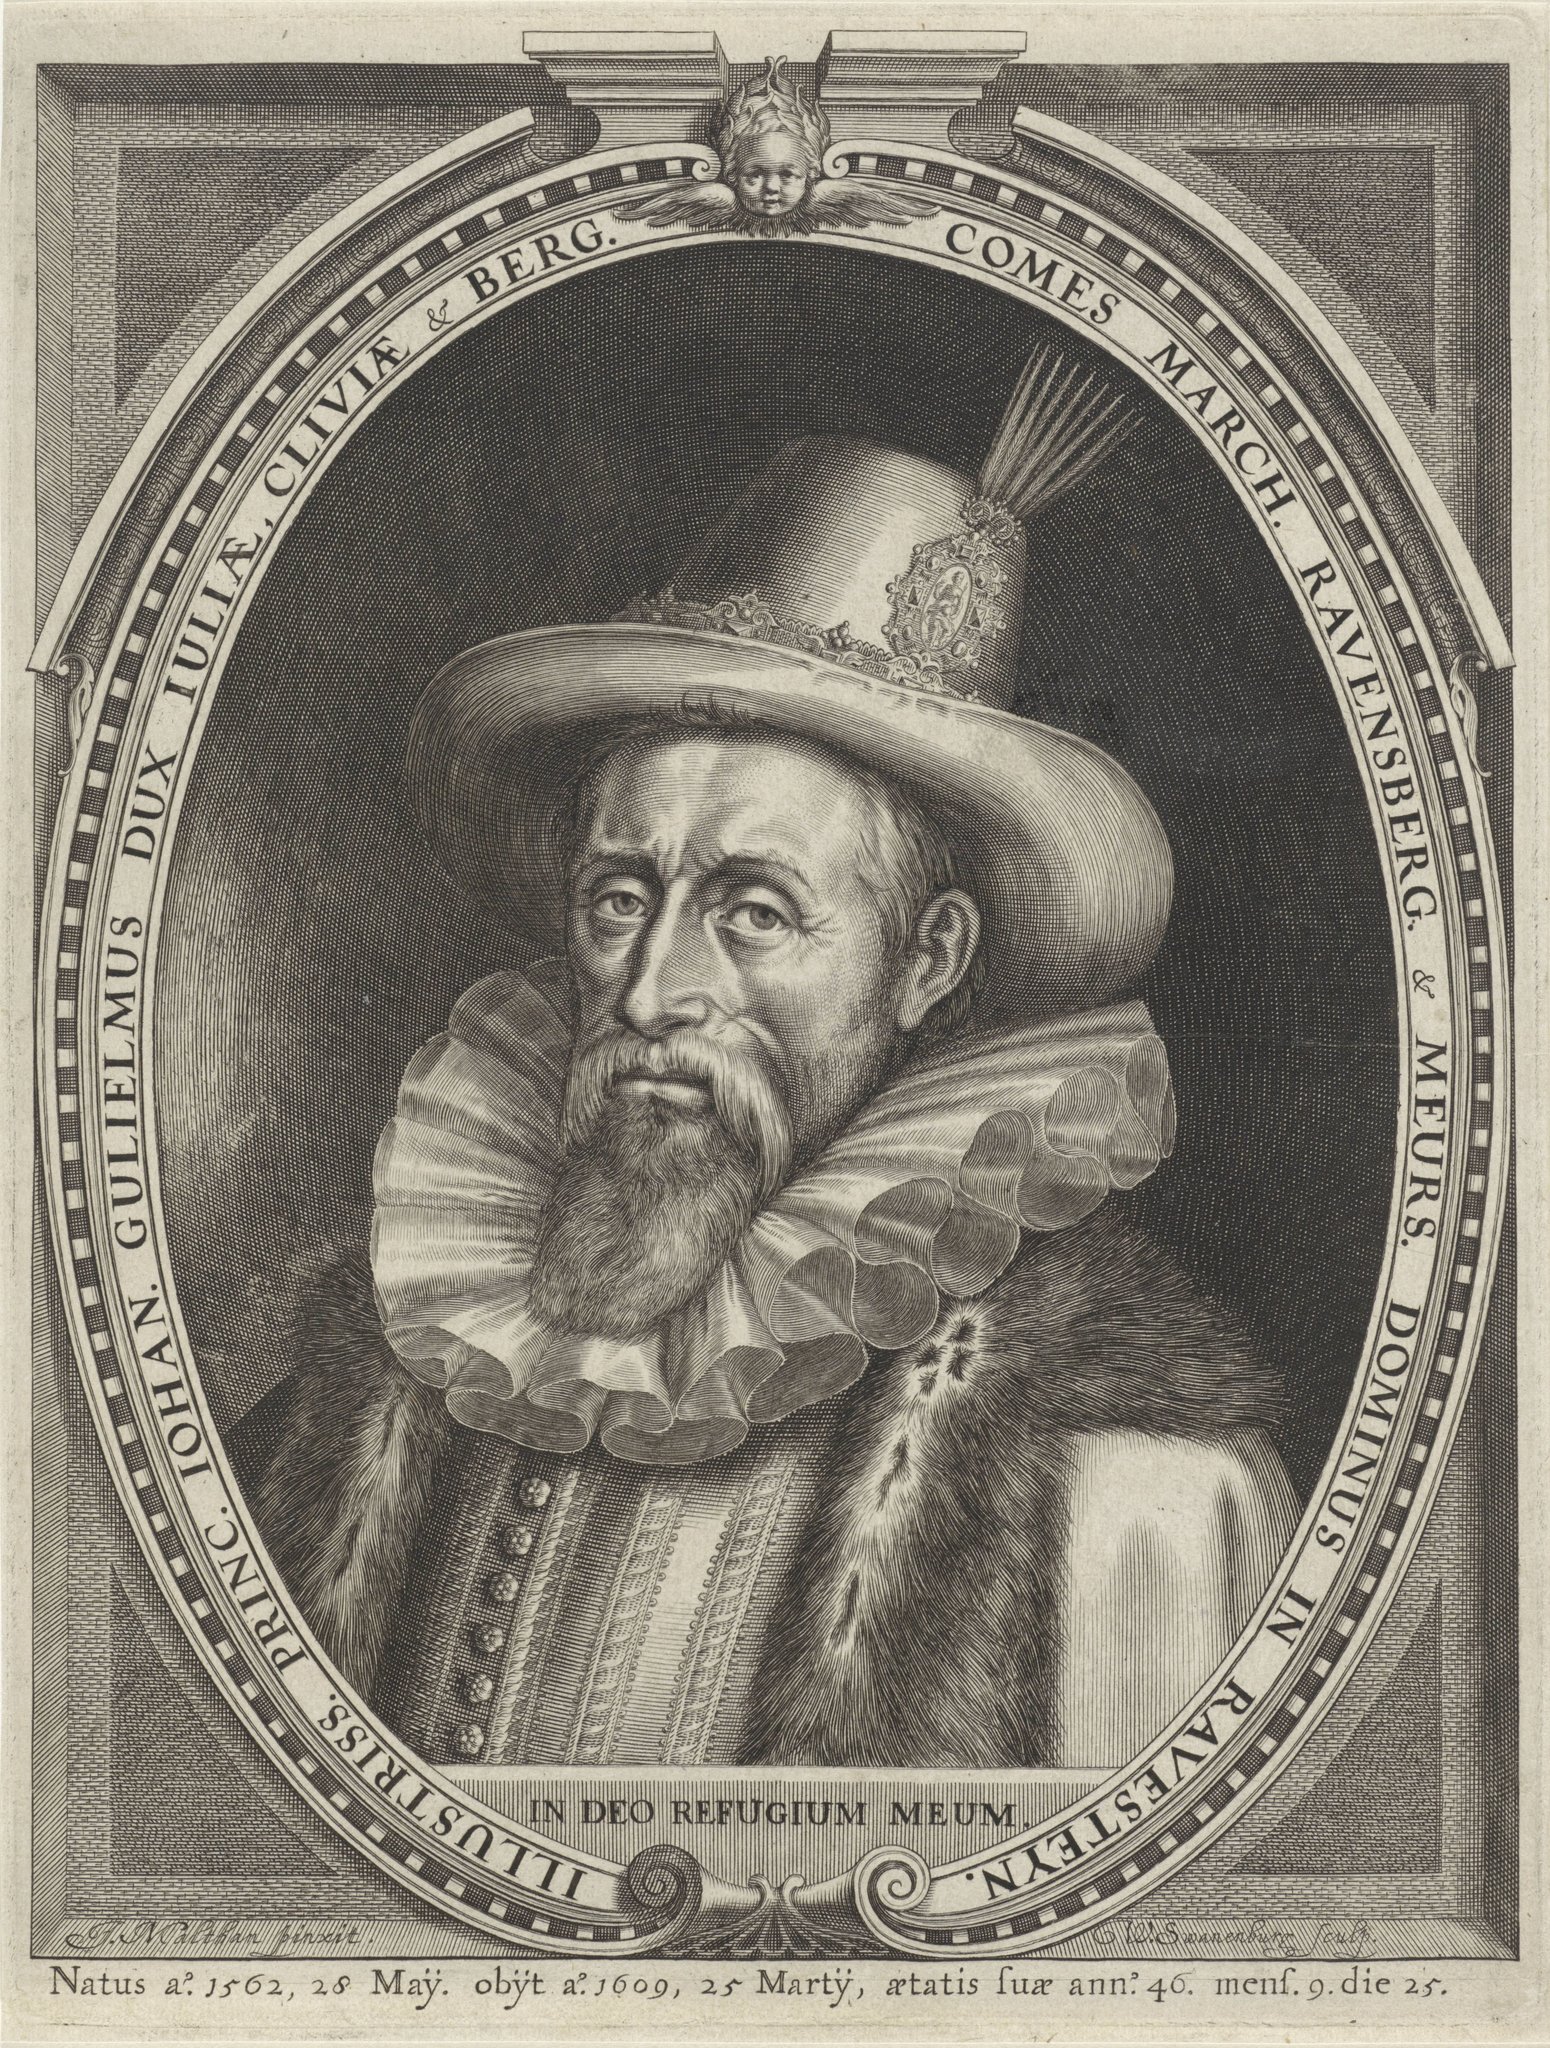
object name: print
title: Portret van Johan Willem van Kleef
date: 1608-1609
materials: paper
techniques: engraving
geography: leiden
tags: hertog, johan willem van kleef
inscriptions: collector's mark: Lugt 2228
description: Portret van Johan Willem van Kleef, hertog van Kleef, Gulik en Berg en graaf van Ravensburg en de heerlijkheid Ravenstein, met een hoed op het hoofd.